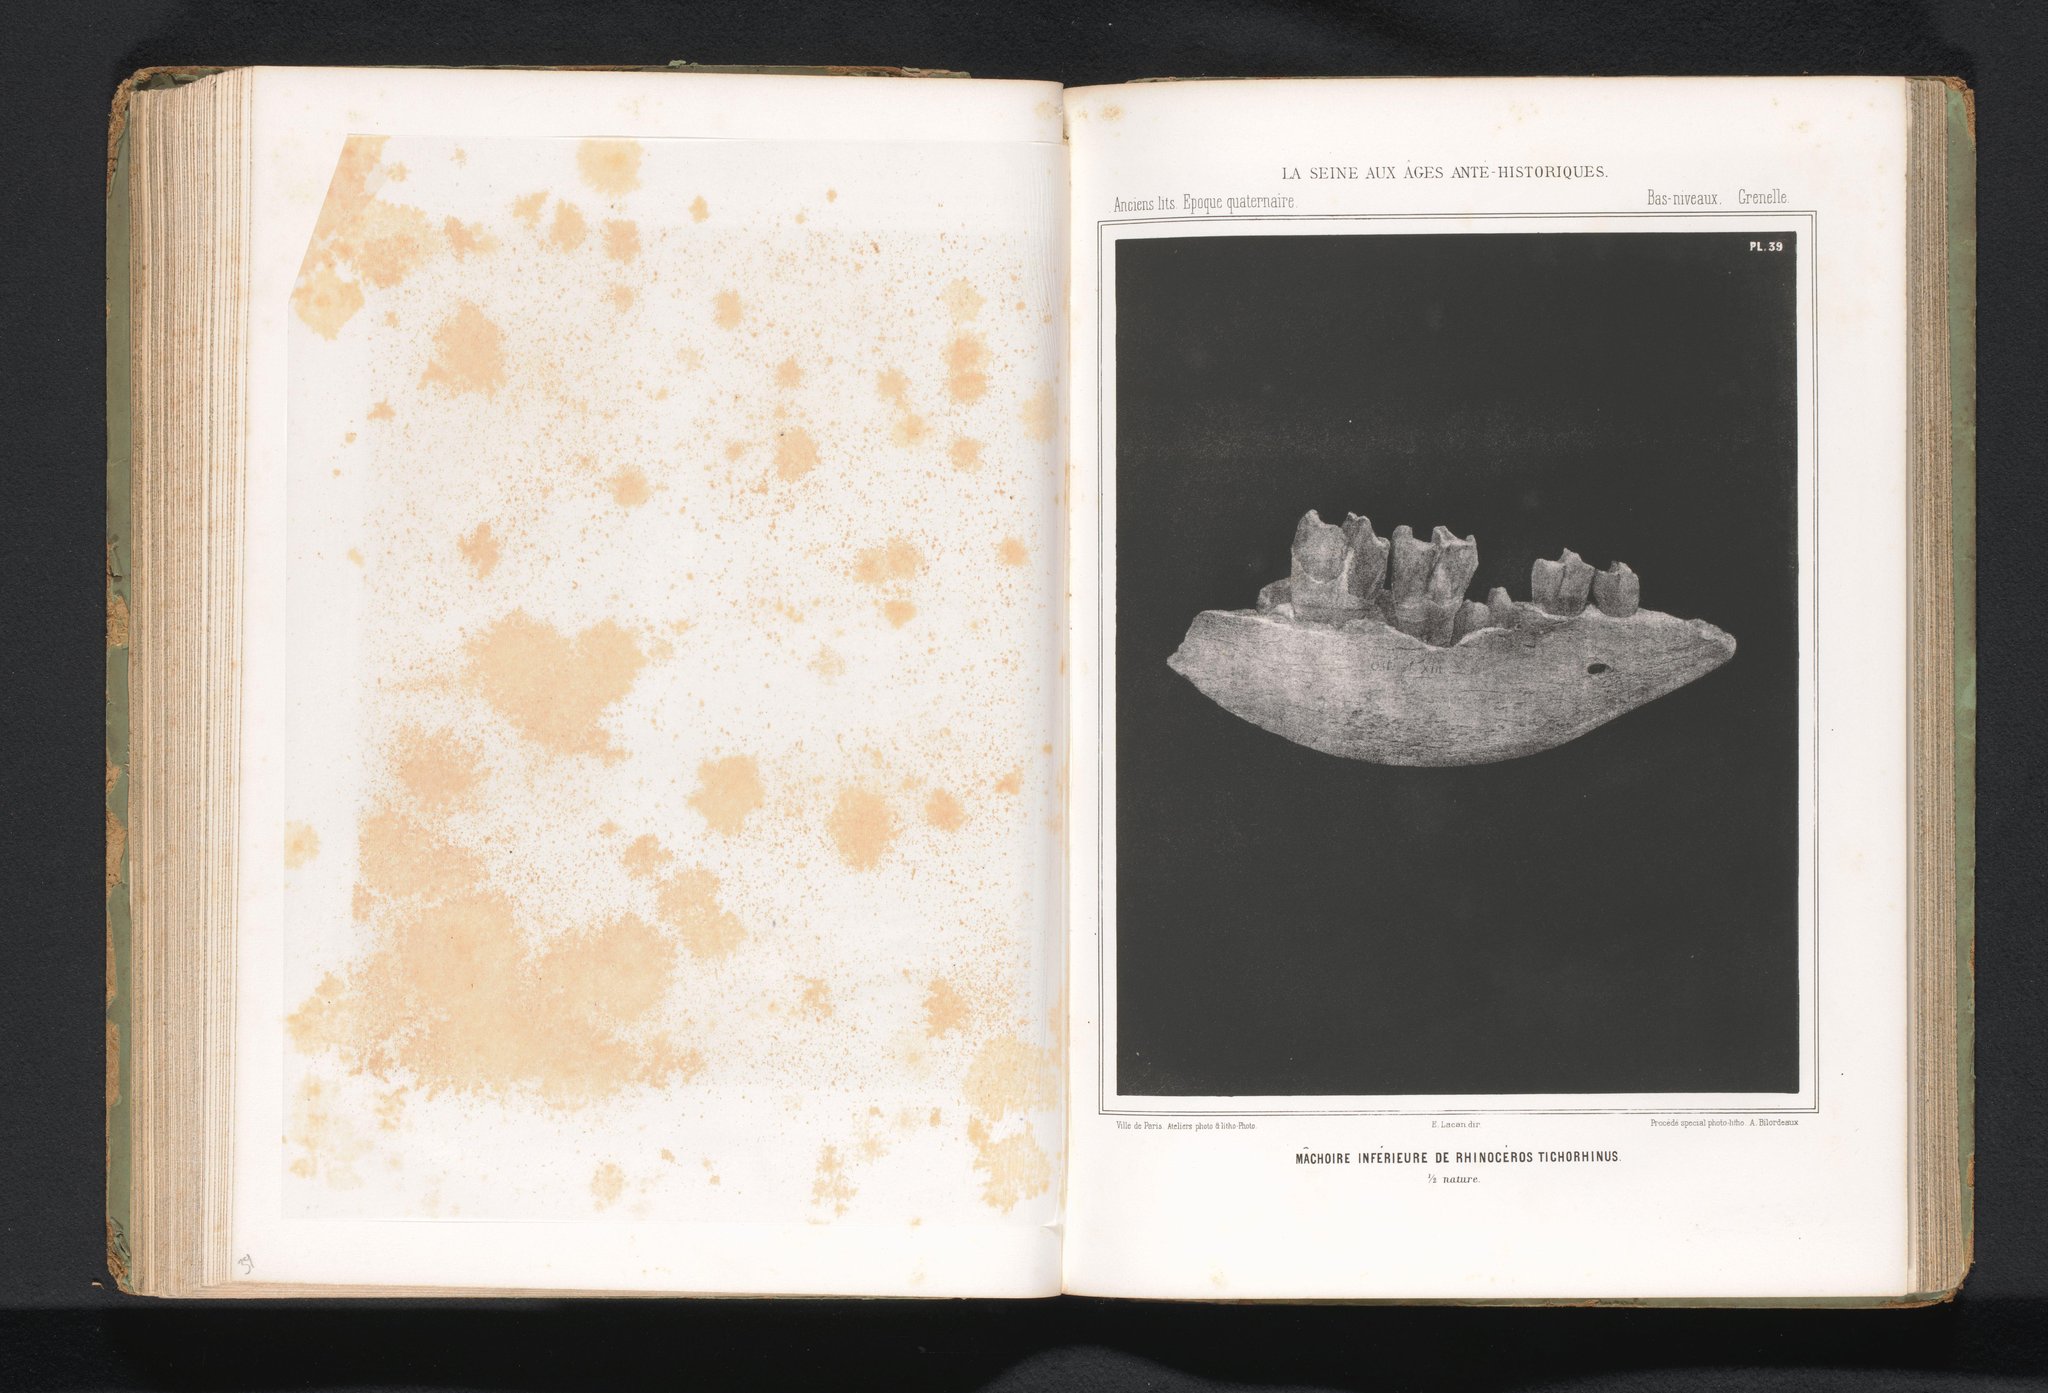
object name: page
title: Onderkaak van een wolharige neushoorn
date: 1864-1869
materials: paper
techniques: photolithography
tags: animals (+ skeleton of an animal), palaeontology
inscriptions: inscription: ‘PL. 39’, inscription: ‘Procédé spécial photo-litho. A. Bilordeaux’, inscription: ‘1/2 nature’